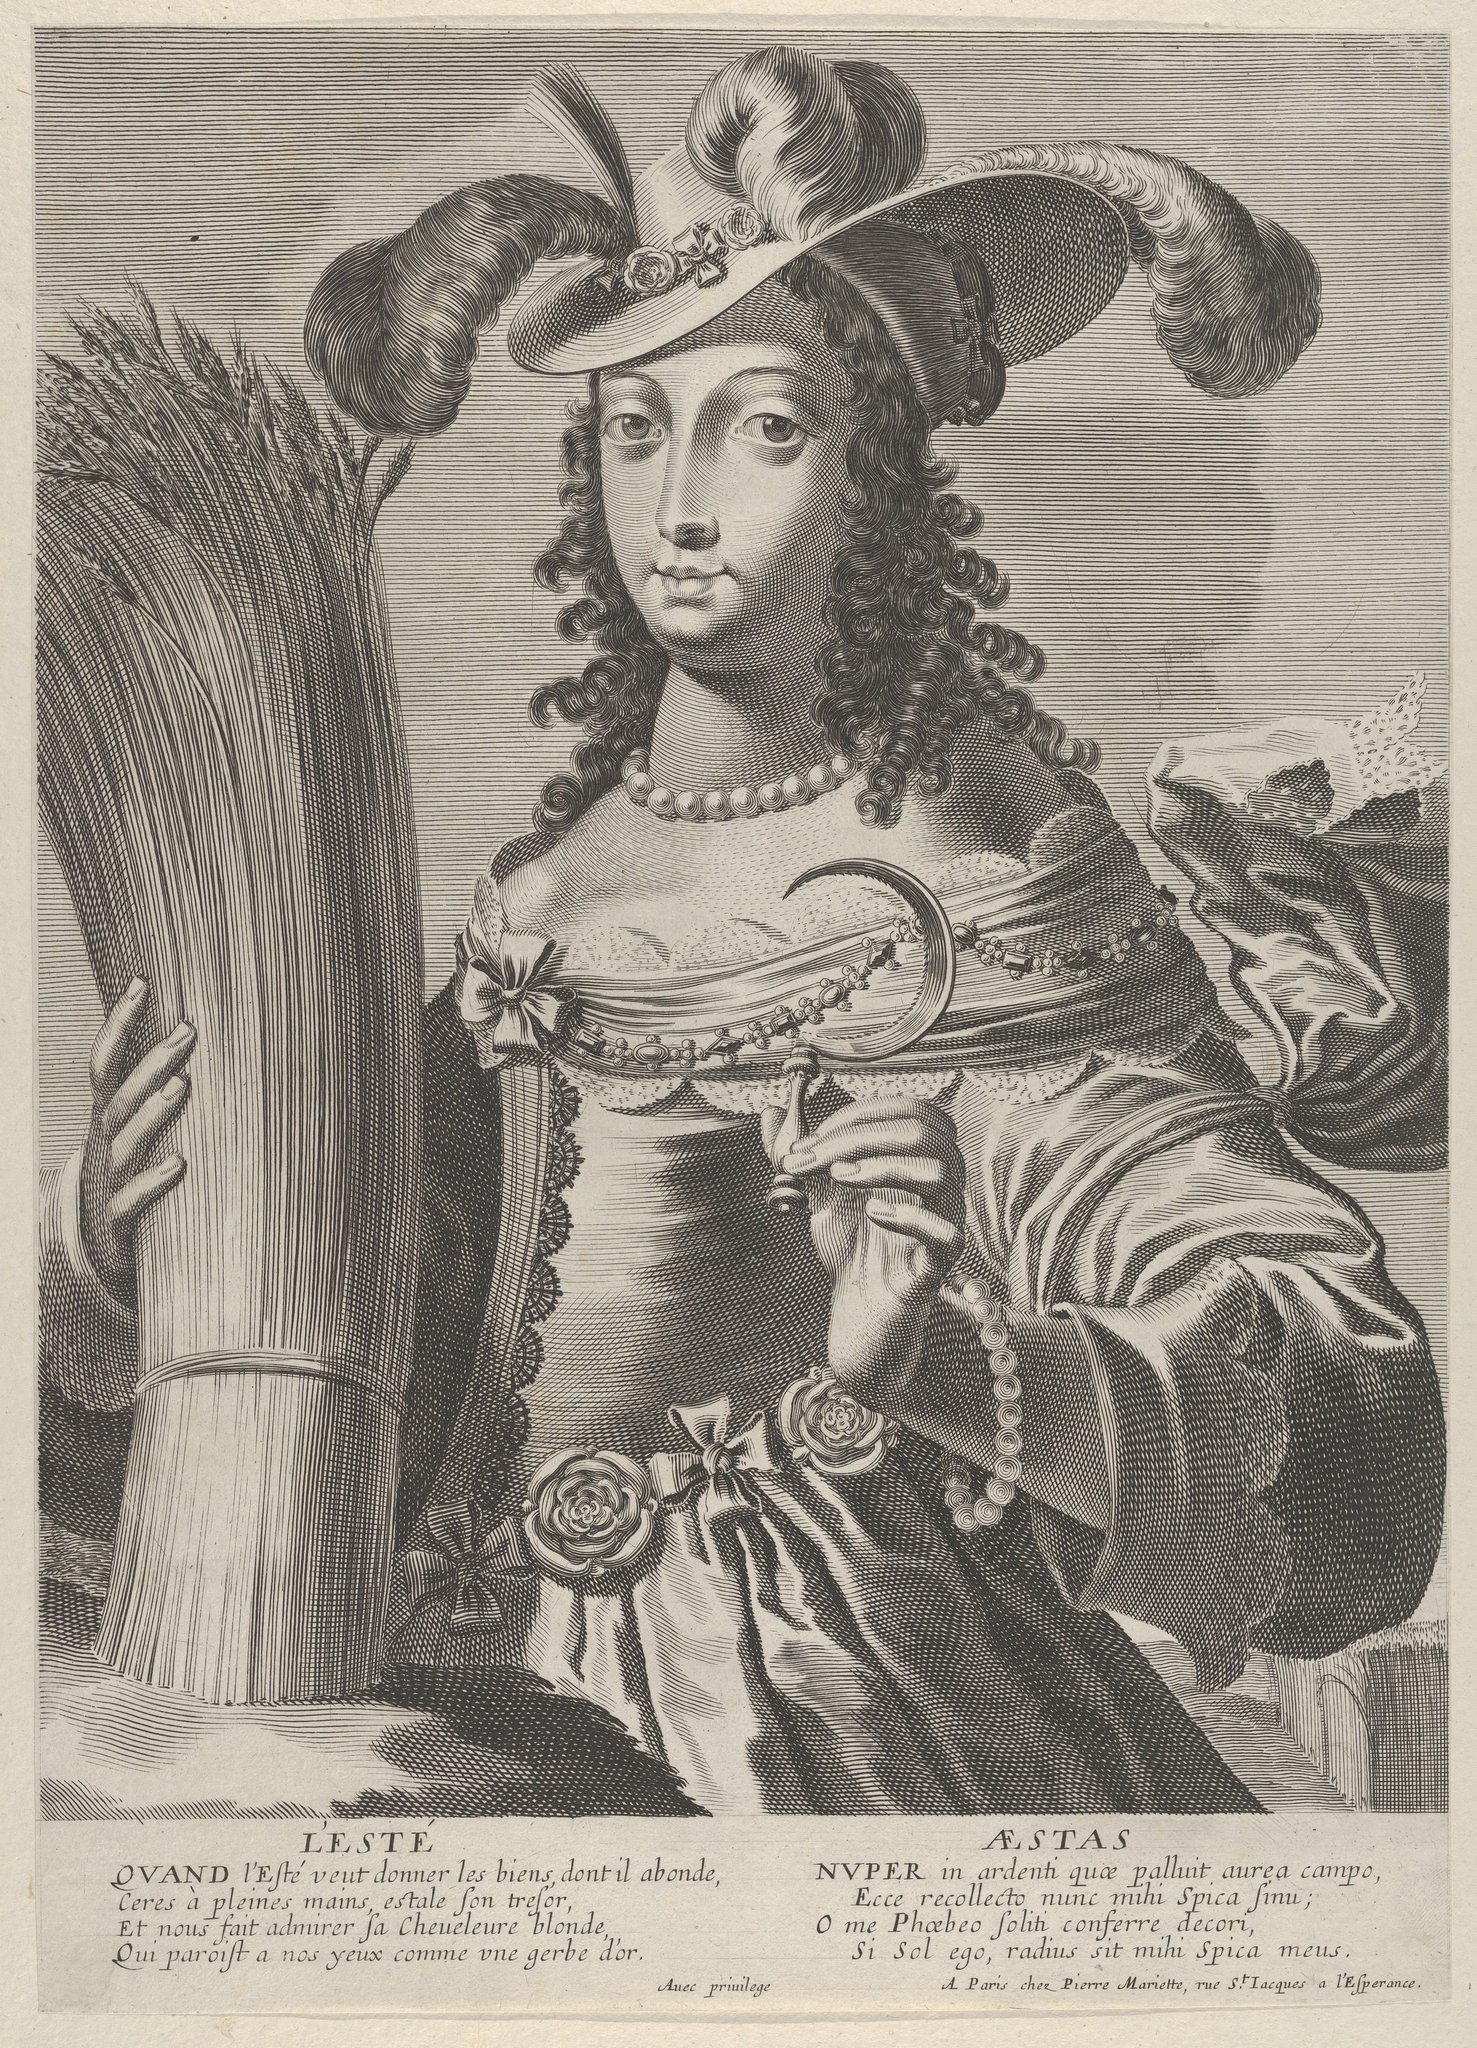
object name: print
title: Summer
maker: grégoire huret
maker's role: artist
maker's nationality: french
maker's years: 1606-1670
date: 1620-1670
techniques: engraving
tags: women,tools